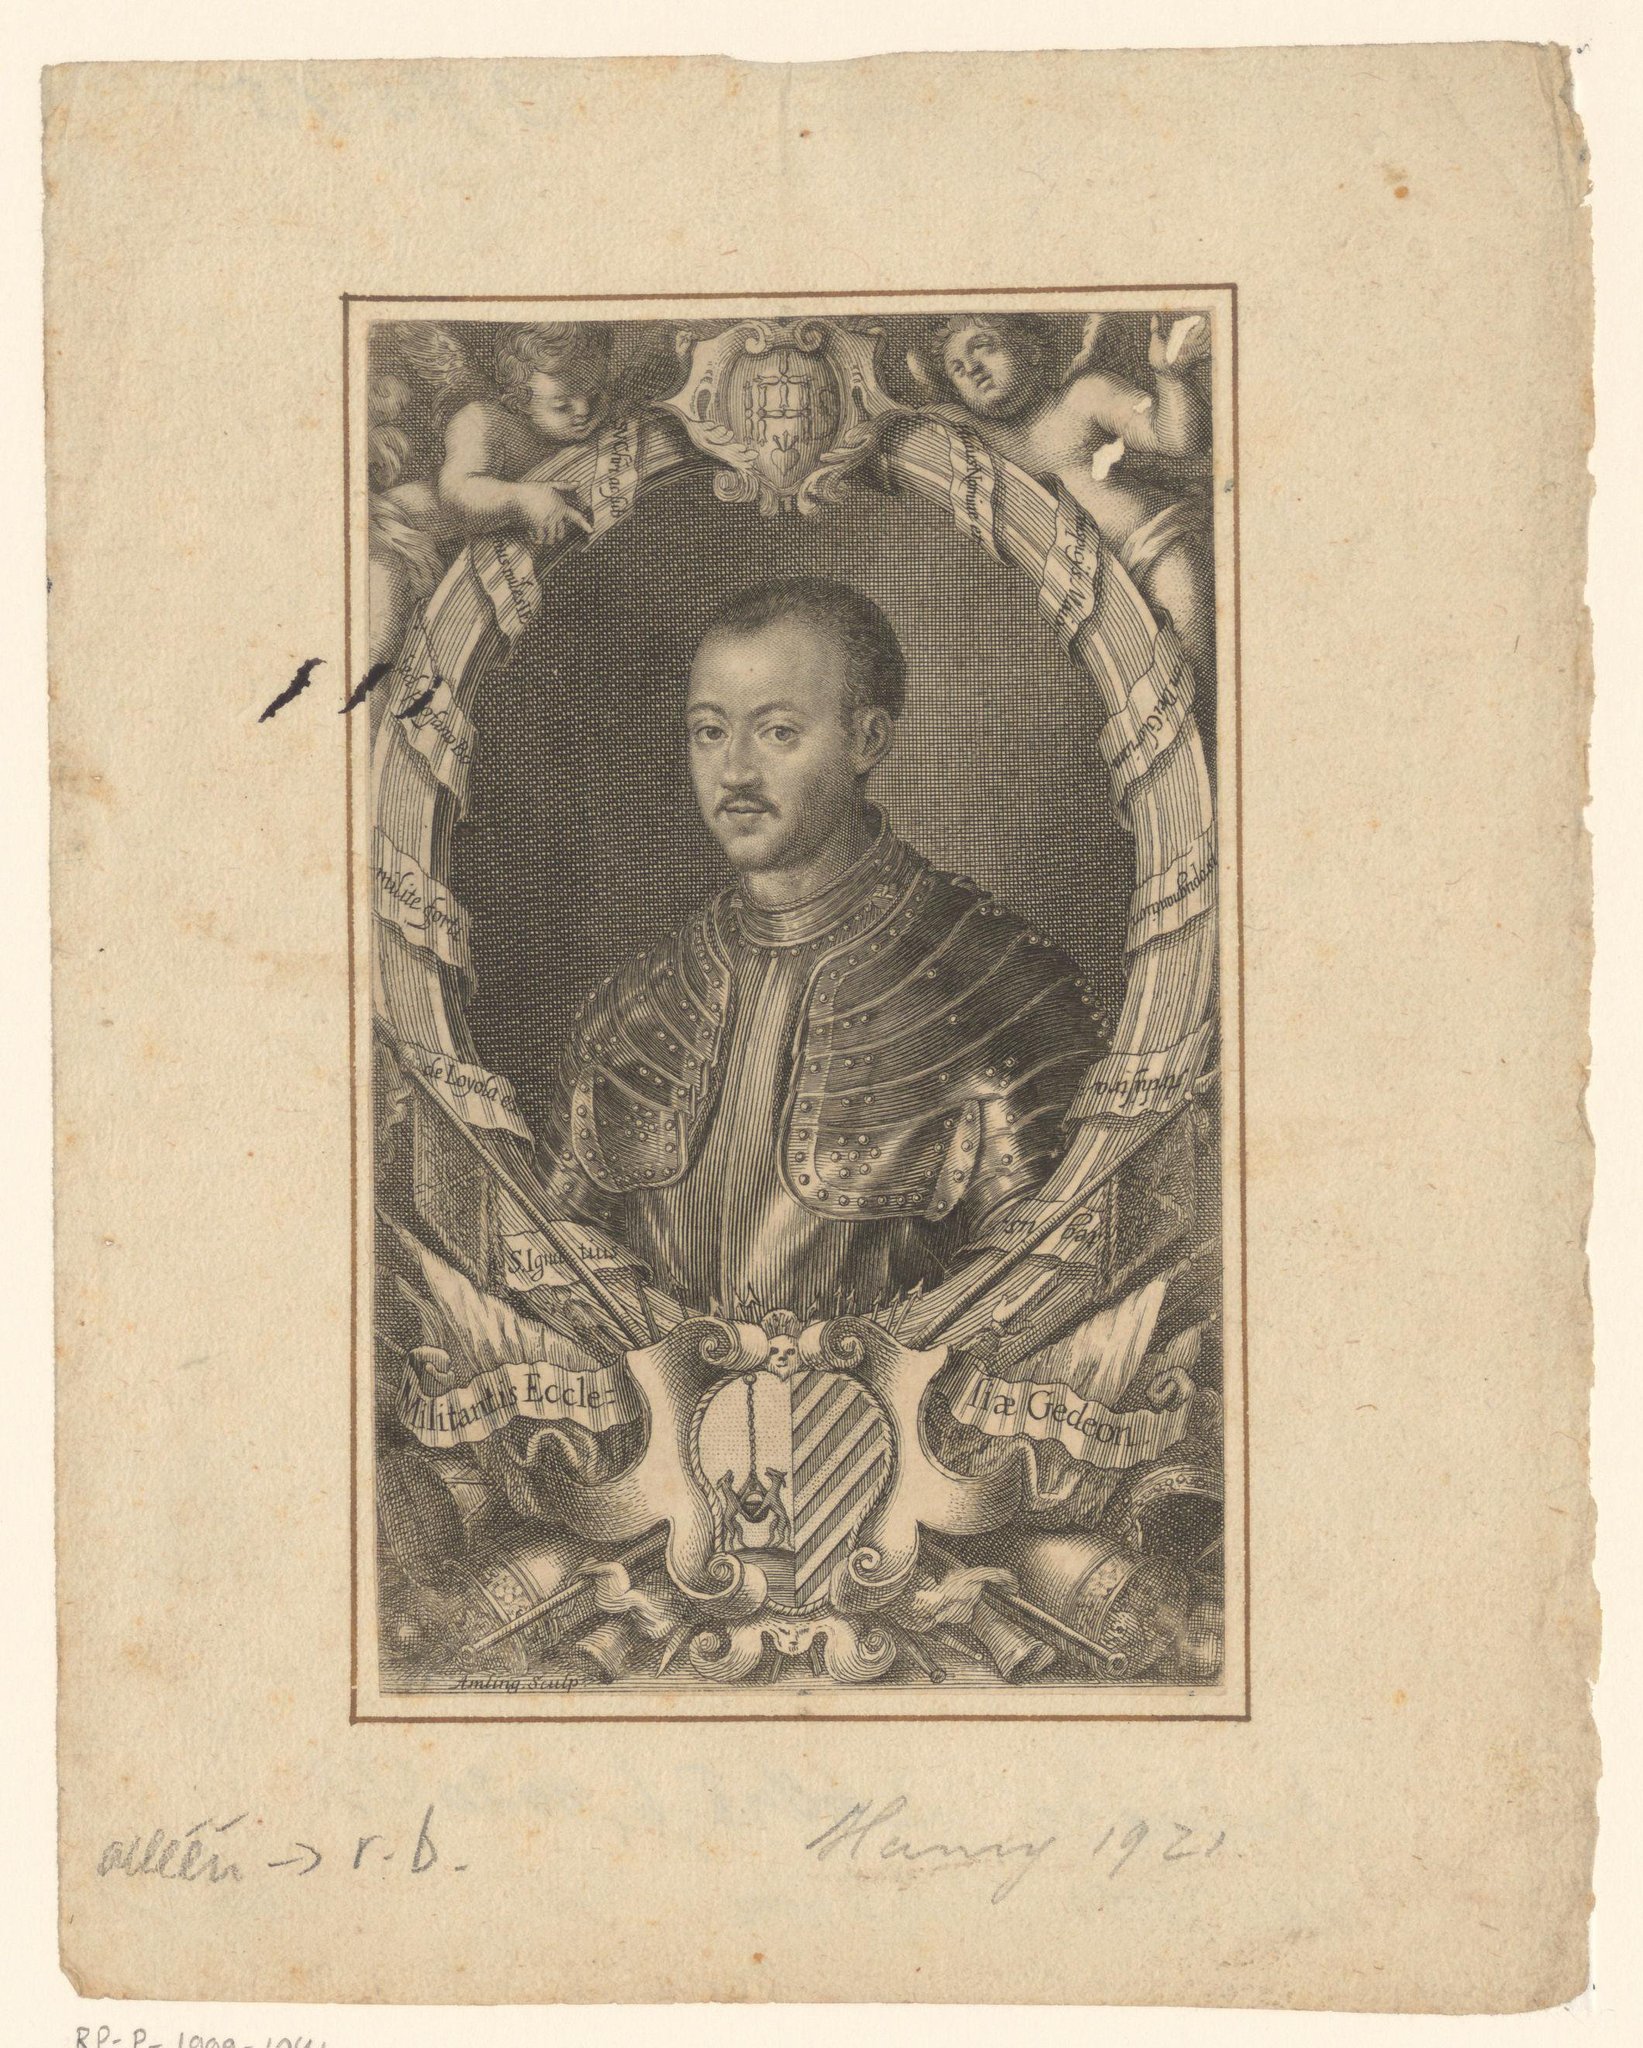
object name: print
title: Portret van Ignatius van Loyola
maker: karl gustav amling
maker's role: print maker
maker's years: 1651-1702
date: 1670-1702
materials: paper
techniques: engraving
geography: munich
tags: rome, clergyman, armour, the founder of the jesuit order, ignatius of loyola; possible attributes: book (with 'ad majorem dei gloriam'), demon, dragon under feet, flames, flaming heart, globe, ihs monogram, skull (with crown), tears in eyes, torch, banner, standard (as symbol of the state, etc.), armorial bearing, heraldry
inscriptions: collector's mark: Lugt 2760, collector's mark: Lugt 2228